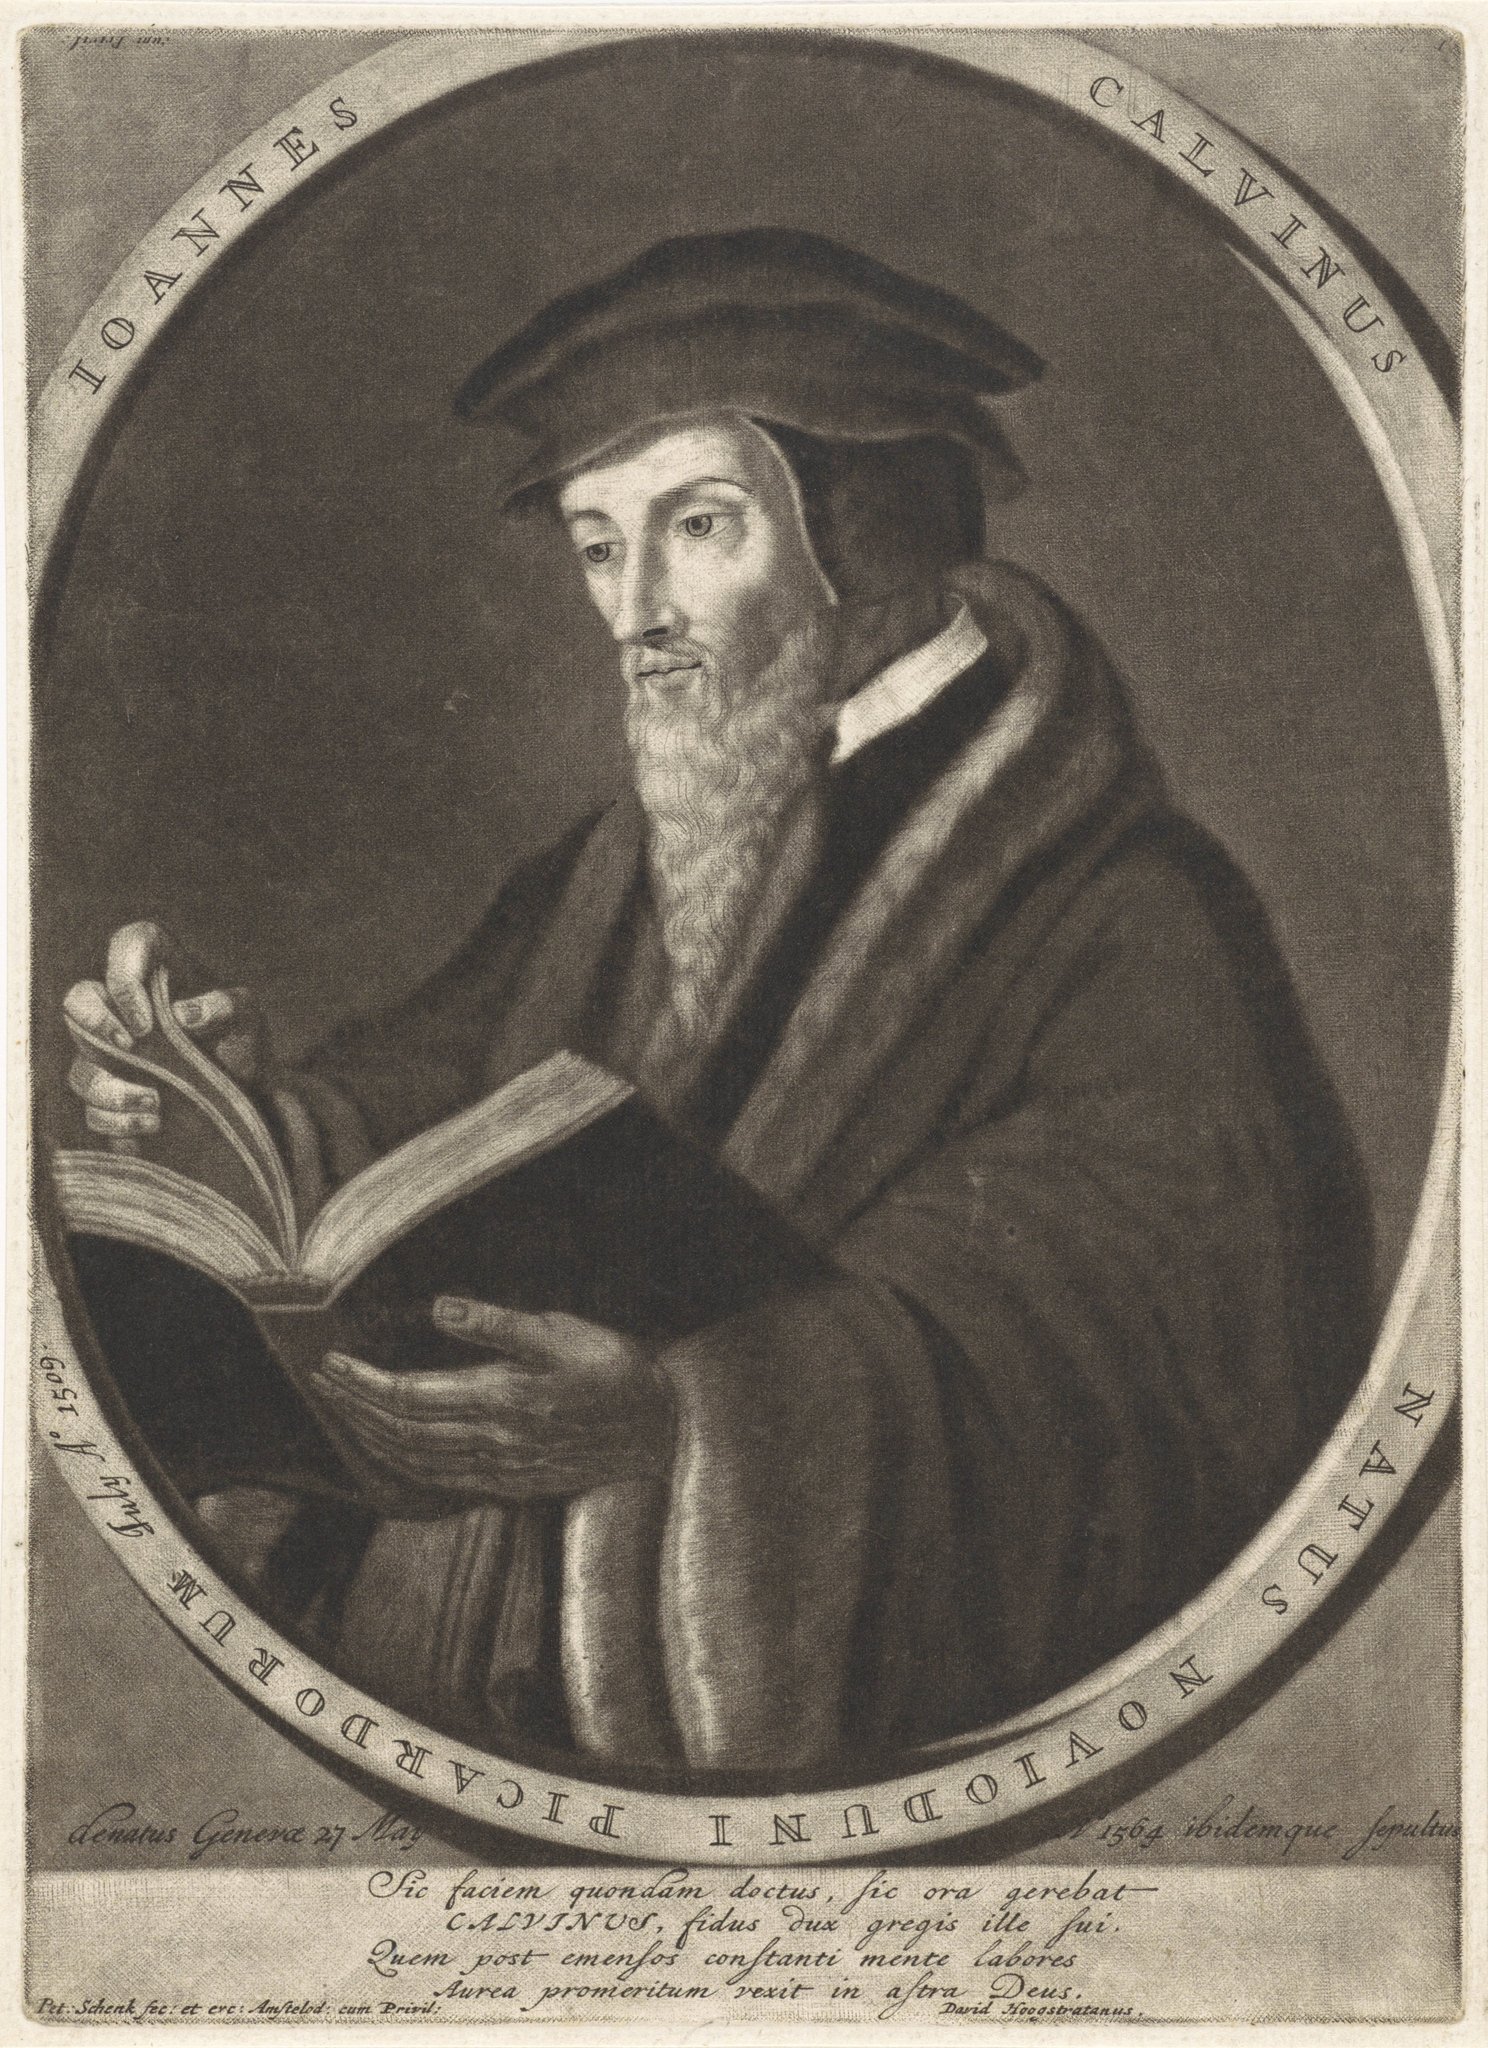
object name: print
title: Portret van Johannes Calvijn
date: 1670-1713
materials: paper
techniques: engraving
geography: amsterdam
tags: book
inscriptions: collector's mark: Lugt 2228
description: De kerkhervormer Johannes Calvijn, met hoofddeksel. In zijn handen een opengeslagen boek. Boven de marge zijn geboorte- en sterfdatum.